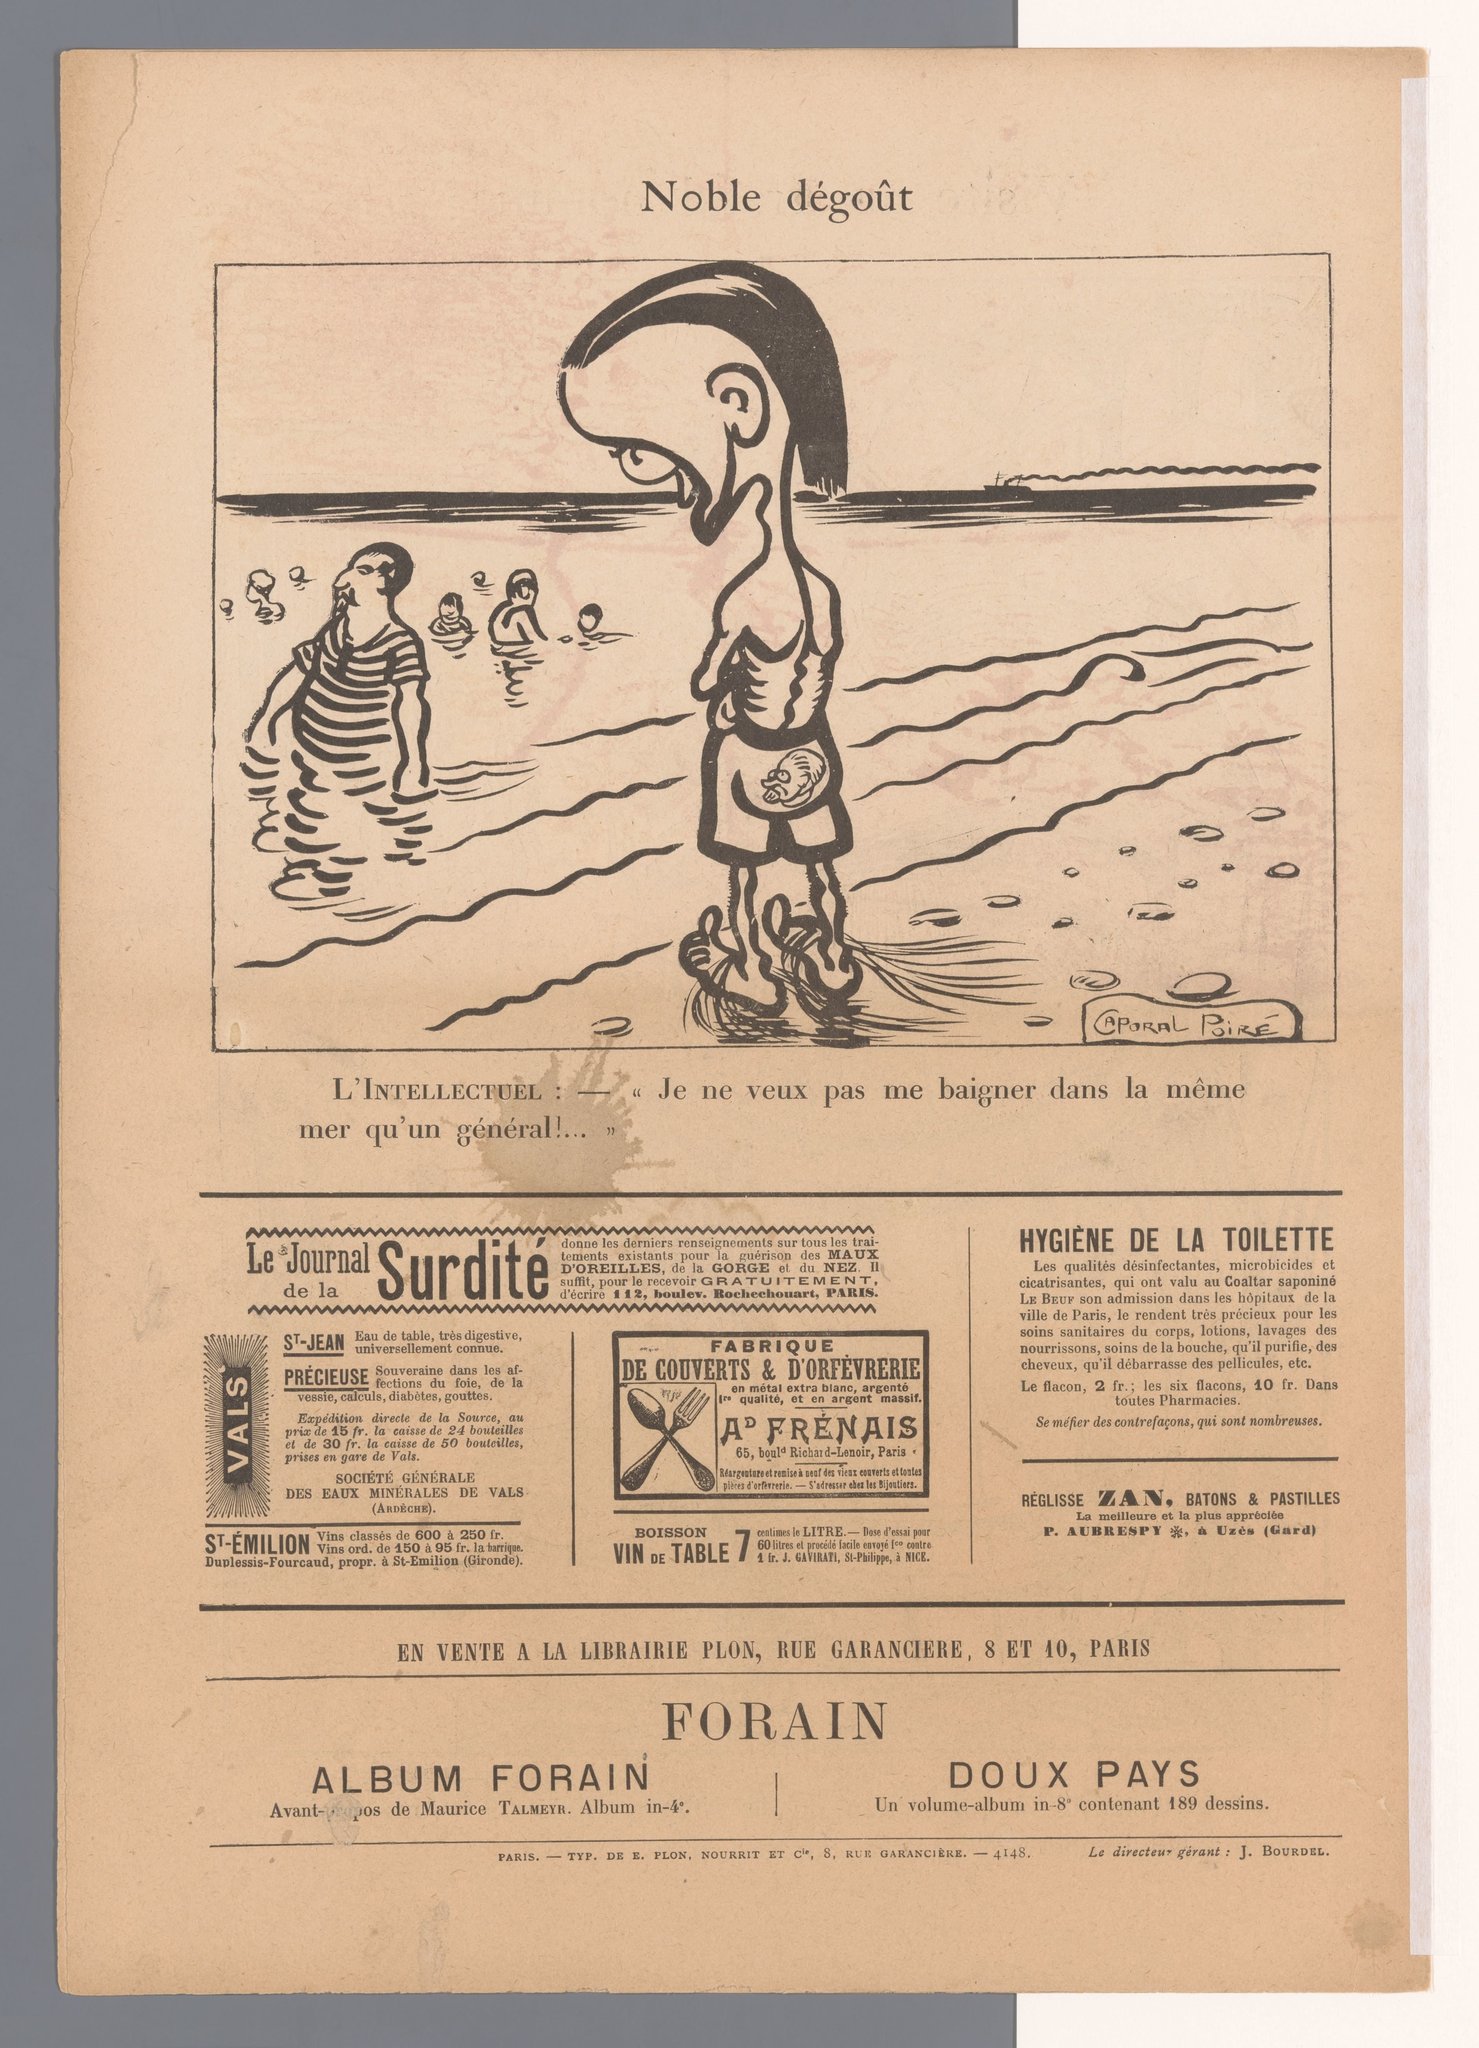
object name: leaflet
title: Karikatuur van een intellectueel aan het strand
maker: jean-louis forain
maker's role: painter, print maker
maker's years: 1852-1931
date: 1898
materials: paper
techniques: lithograph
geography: paris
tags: caricatures (human types), political caricatures and satires, in or beside the water (on the beach)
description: Prent gebruikt voor: Psst...!, nr. 29, 20 augustus 1898. Psst..! was een politieke weekkrant met antisemitische en anti-Dreyfus cartoons.